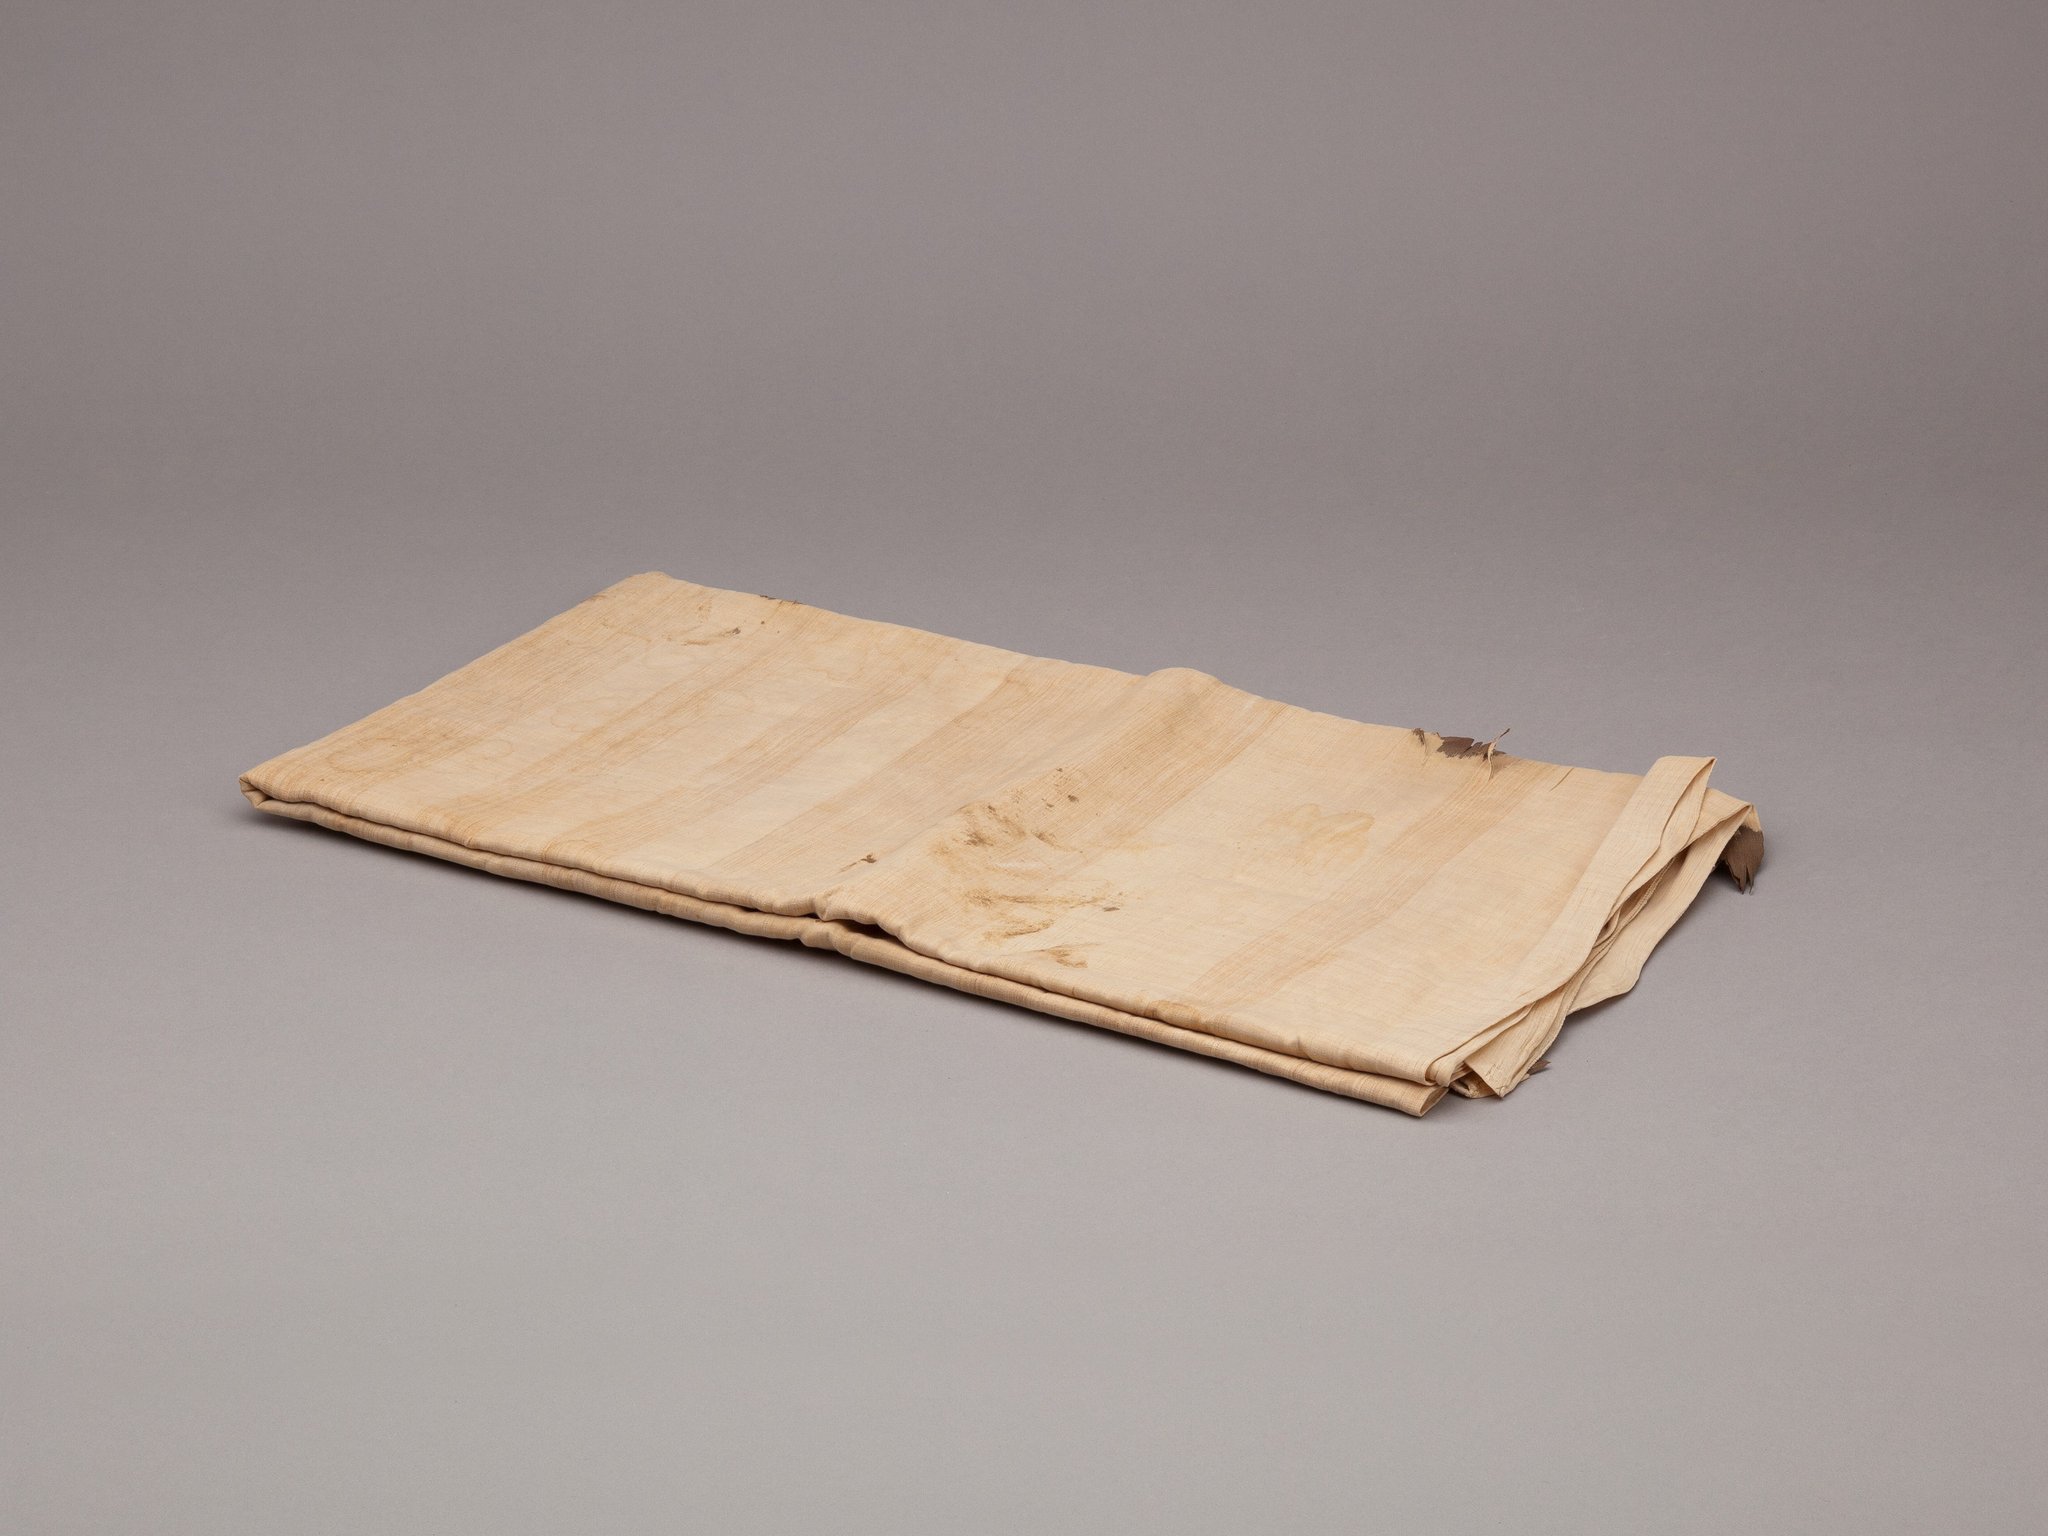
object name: shirt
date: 1492-1473 BCE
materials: linen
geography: egypt